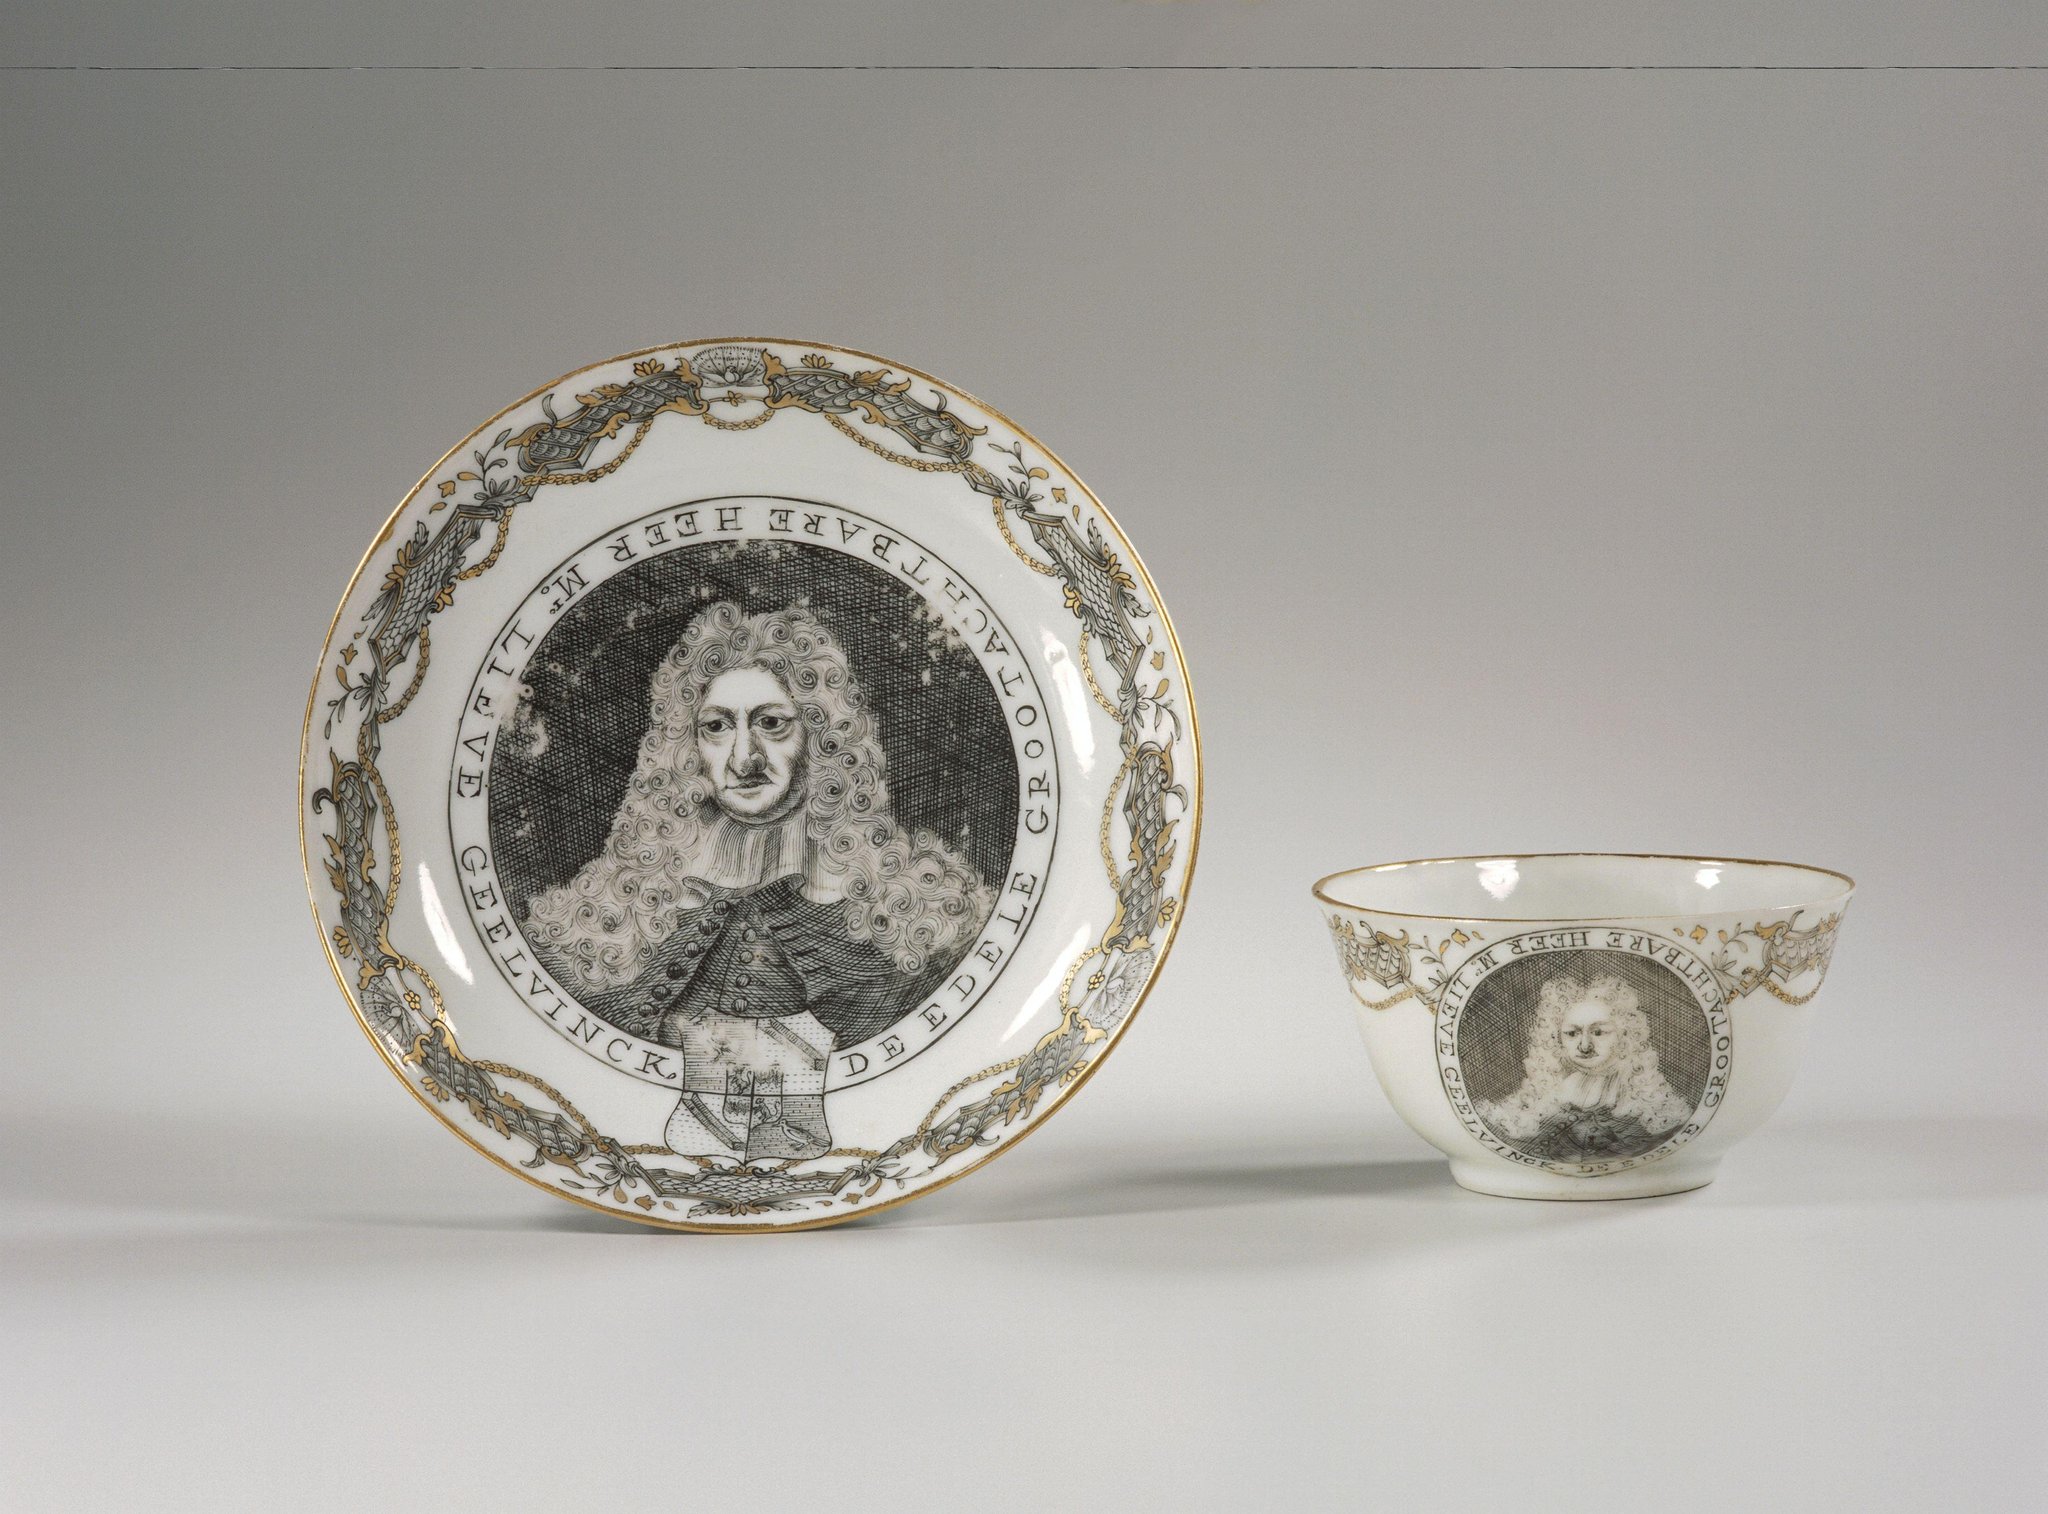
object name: kop en schotel, kop en schotel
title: Bell-shaped cup and saucer with a portrait of Lieve Geelvinck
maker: Anonymous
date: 1760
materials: glaze, gold, paint, porcelain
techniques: firing, gilding, turning, vitrification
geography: china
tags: amsterdam, mayor, lieve geelvinck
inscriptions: inscription: ‘DE EDELE GROOTACHTBARE HEER Mr. LIEVE GEELVINCK’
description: Het portret is een nauwkeurige kopie naar een gravure uit 1758 door Jacob Houbraken (1698-1780) en gebaseerd op een schilderij van Jan Wandelaar (1690-1759). Geelvinck was naast burgemeester van Amsterdam ook één van de directeuren van de VOC. Dit bood hem een uitstekende gelegenheid om Chine de commande porselein in China te laten vervaardigen. Hij bezat eveneens een polychroom servies voorzien van zijn wapen. Ook is een bord bekend met een allegorische voorstelling op zijn huwelijk met Jacoba Graafland in 1729. (C.J.A. Jörg en Jan van Campen, Chinese Ceramics in the Rijksmuseum, Londen 1997, p. 280)